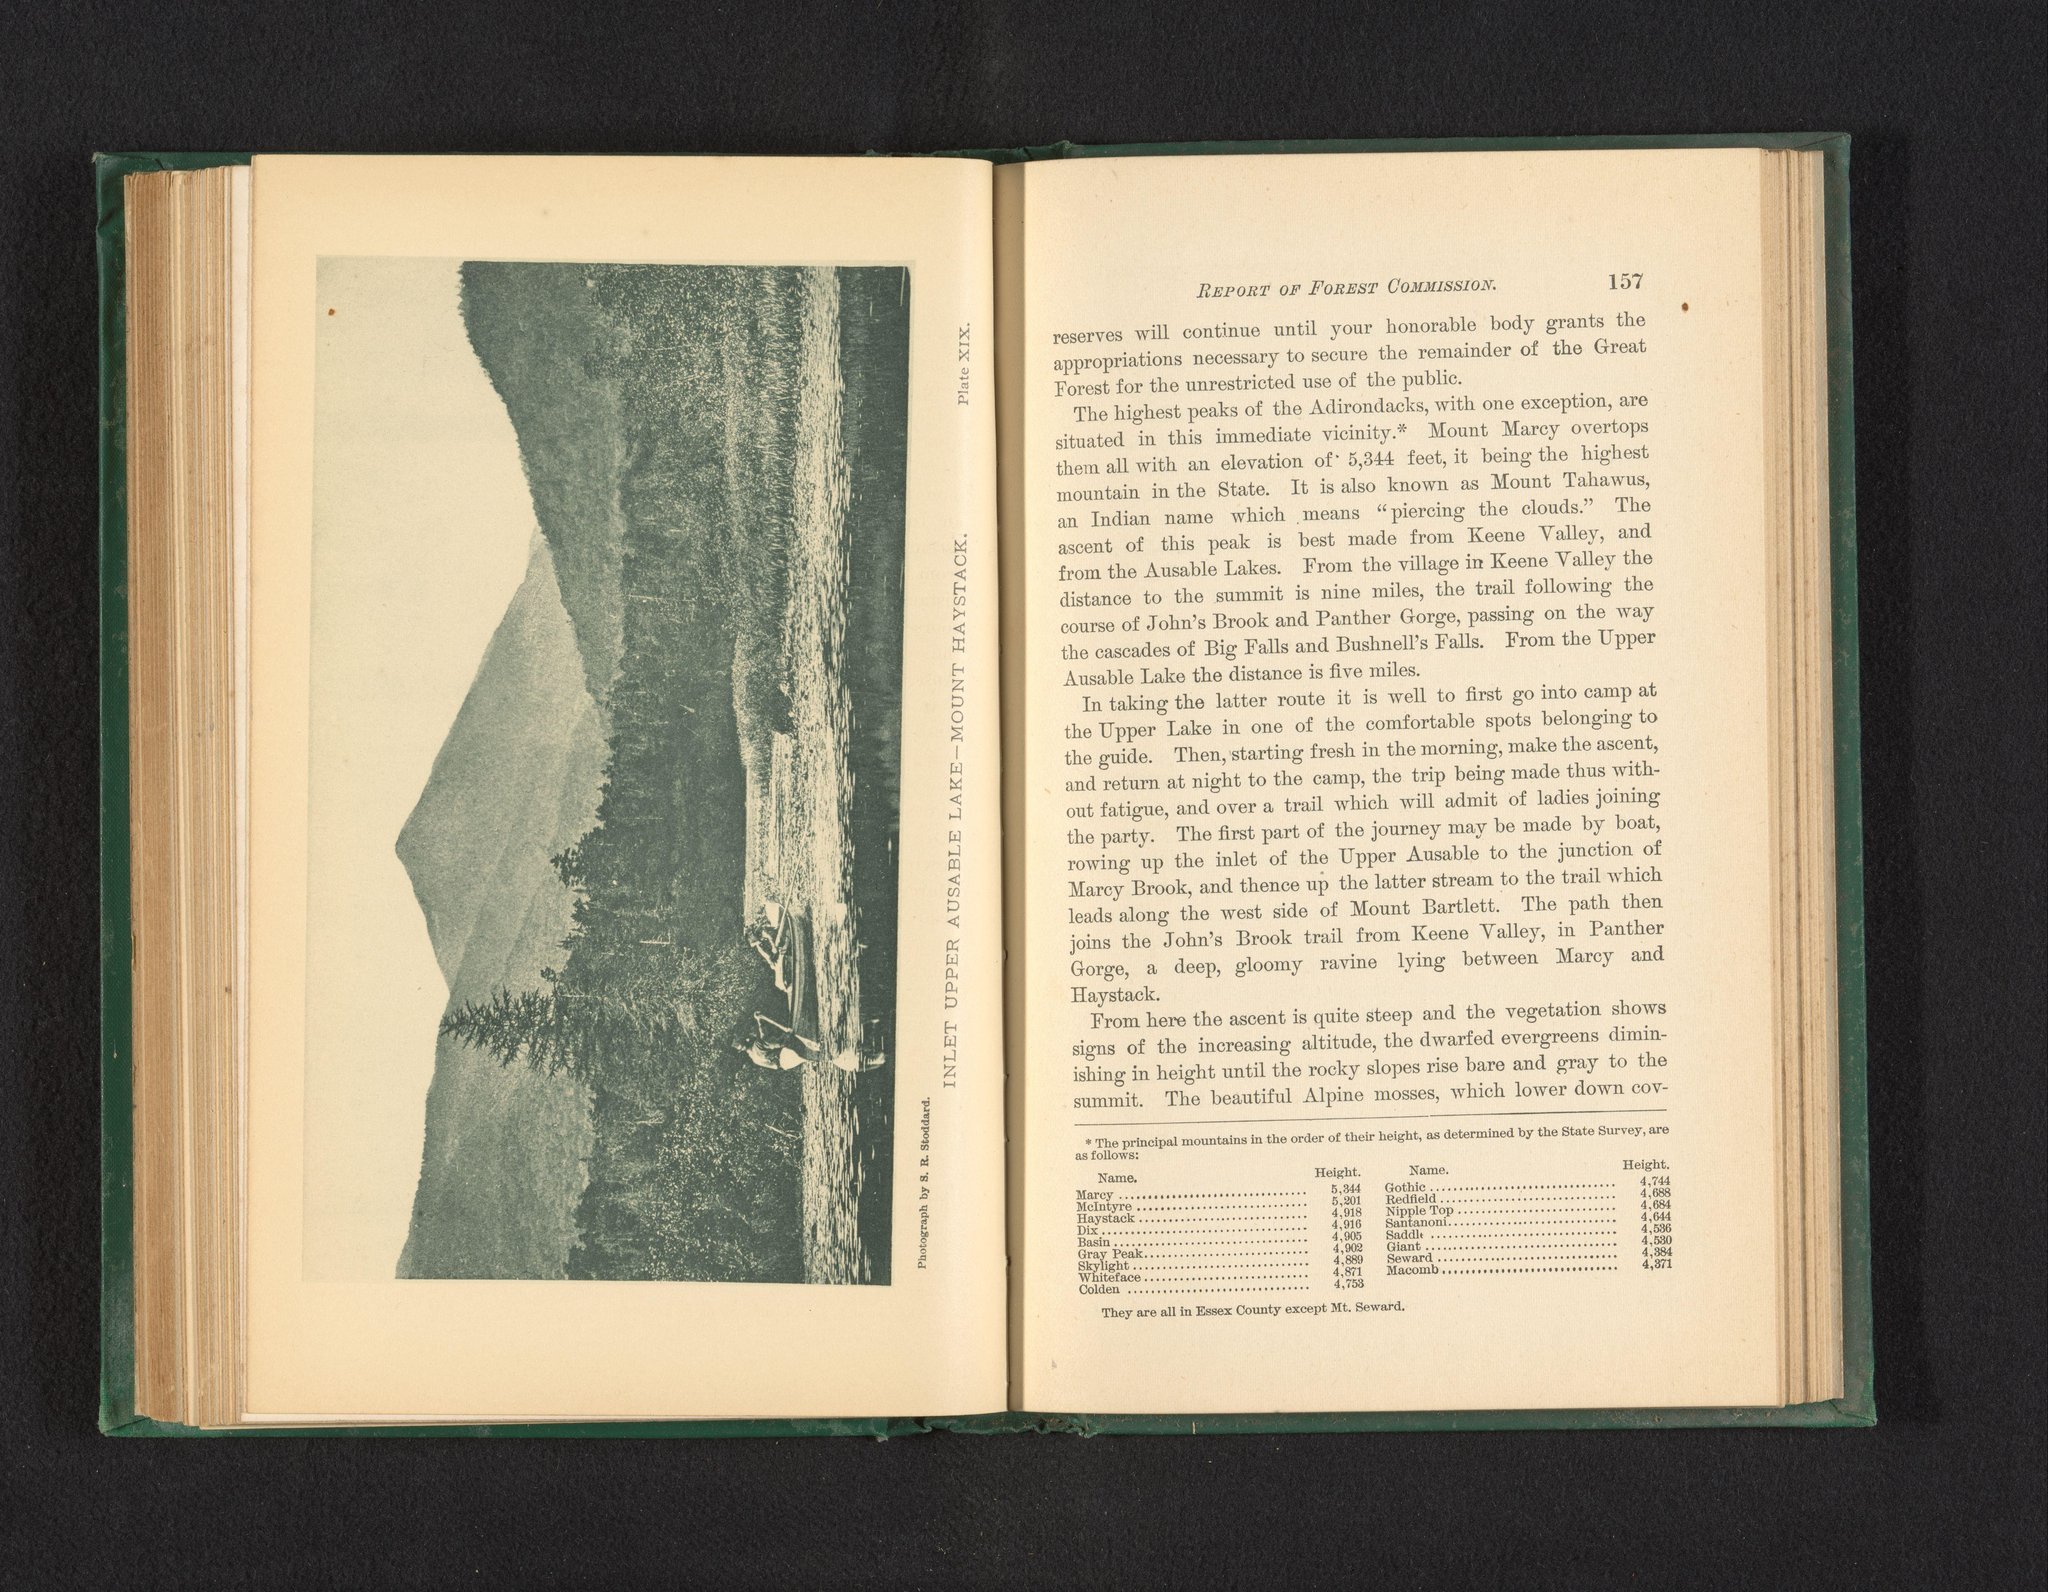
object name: photomechanical print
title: Inlet Upper Ausable Lake-Mount Haystack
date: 1891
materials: paper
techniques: photograph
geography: new york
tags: mountains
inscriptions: number: ‘Plate XIX.’